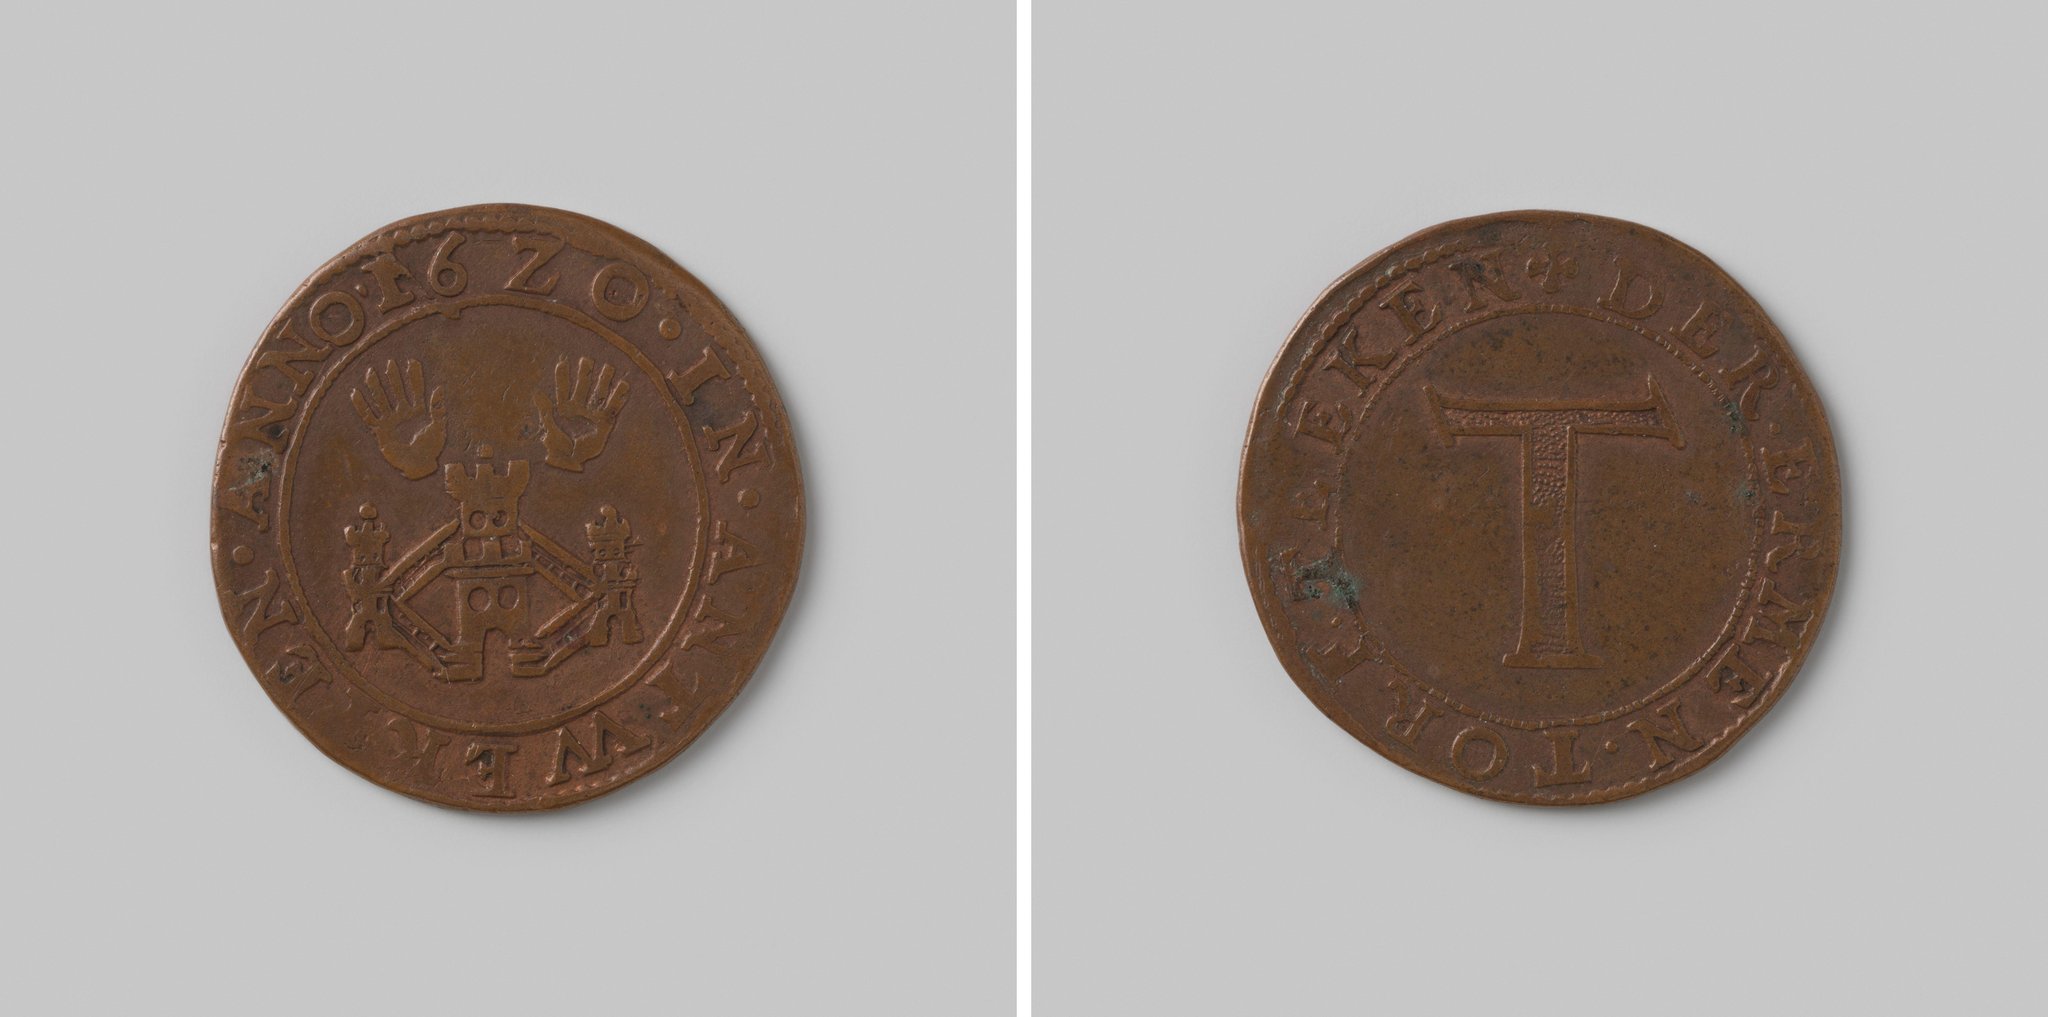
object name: history medal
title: Turfpenning voor de armen van Antwerpen 1620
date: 1620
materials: copper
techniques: striking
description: Koperen penning, op de voorzijde een burcht met poort waarboven twee handjes, met omschrift, op de keerzijde een grote letter T, met omschrift.